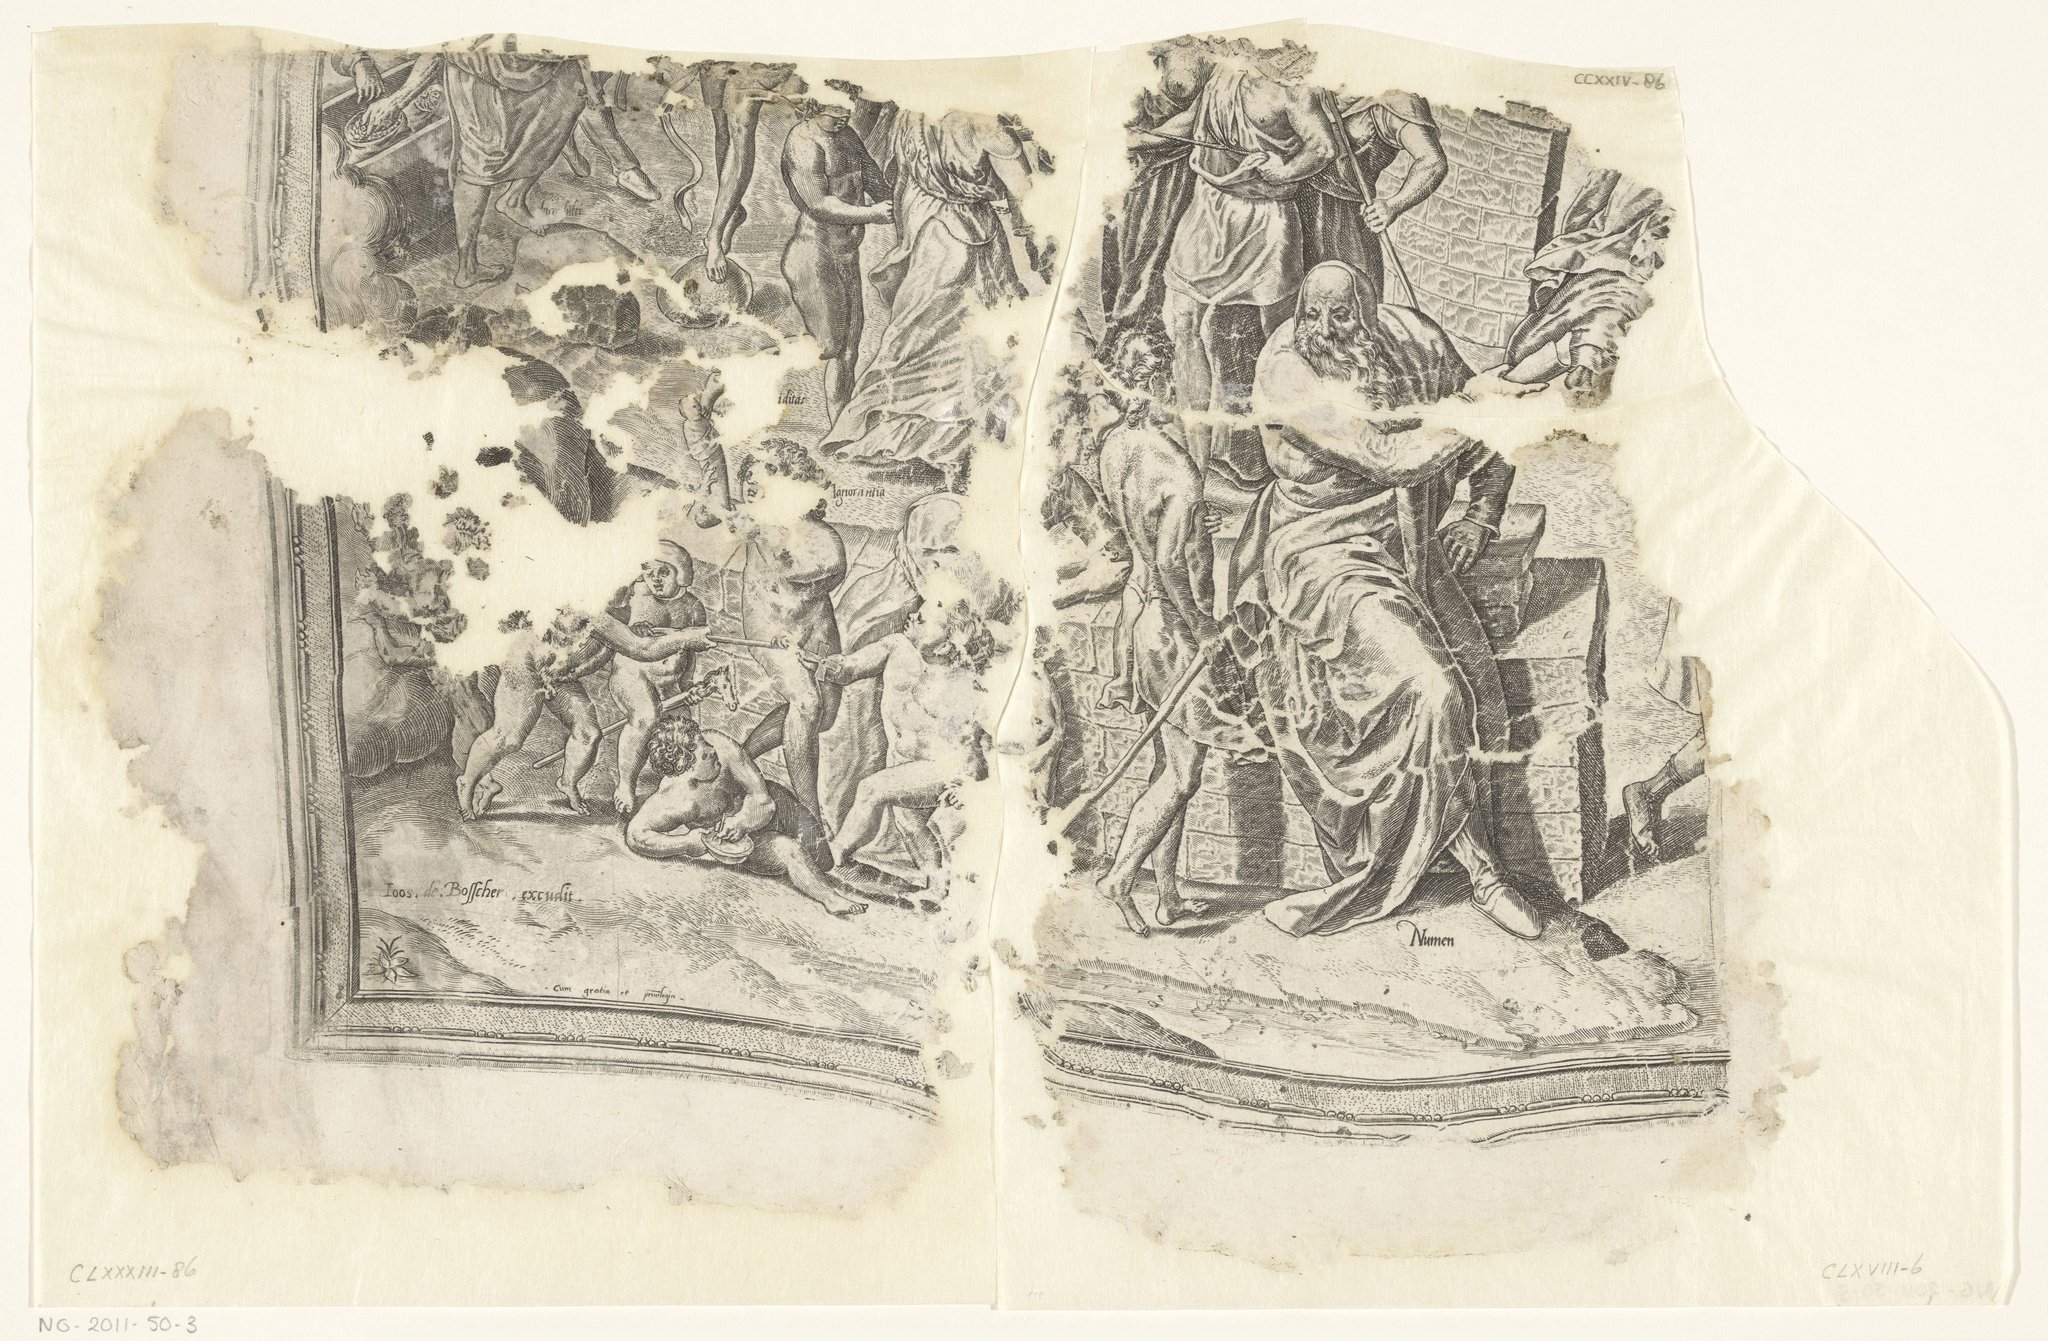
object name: print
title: Tabula Cebetis Carta Vitae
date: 1561-1596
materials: paper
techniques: engraving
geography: southern netherlands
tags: 'tabula cebetis'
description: Allegorie over de heilsweg van de mens. Het leven als een stad met drie ommuurde terreinen, met in het midden een tempel. Bij de buitenste poort staan de zielen van kinderen te wachten, klaar om het volwassen leven te betreden. Voor het binnengaan krijgen zij iets te drinken van Verleiding (Seductio), die hen onwetend maakt. Het eerste ommuurde terrein toont allerlei ver- en afleidingen, zoals Vooroordeel (Opinio), Begeerte (Cupiduas), Twijfel (Error) en Onwetendheid (Ignorantia). Zij beletten de jeugdige mens verder door te dringen tot de volgende cirkel. Alleen door de personificaties te volgen van Berouw (Poenitentia), Hoop (Spes) en Goed Verlangen (Bonnem Desiderium) kan de mens toegang krijgen tot de tweede cirkel. Daar krijgt hij onderricht in alle vormen van wereldse kennis. Links staan de zeven artes liberales en rechts debatteren verschillende geleerden. De mens wordt in deze cirkel op de proef gesteld en geconfronteerd met valse kennis (Falsa Disciplina). Met behulp van Zelfbeheersing (Continentia) en Geduldigheid (Tolerantia) kan de berg verder worden beklommen. Het derde ommuurde terrein, ten slotte, wordt bewaakt door Waarheid (Veritas). Zij verleent de mens toegang tot het ware geluk. Hij wordt er verwelkomd door de kardinale deugden en mag verblijven in het huis van de gelukzaligen, waar het ware geluk op hem wacht. Gereconstrueerd uit drie fragmenten.